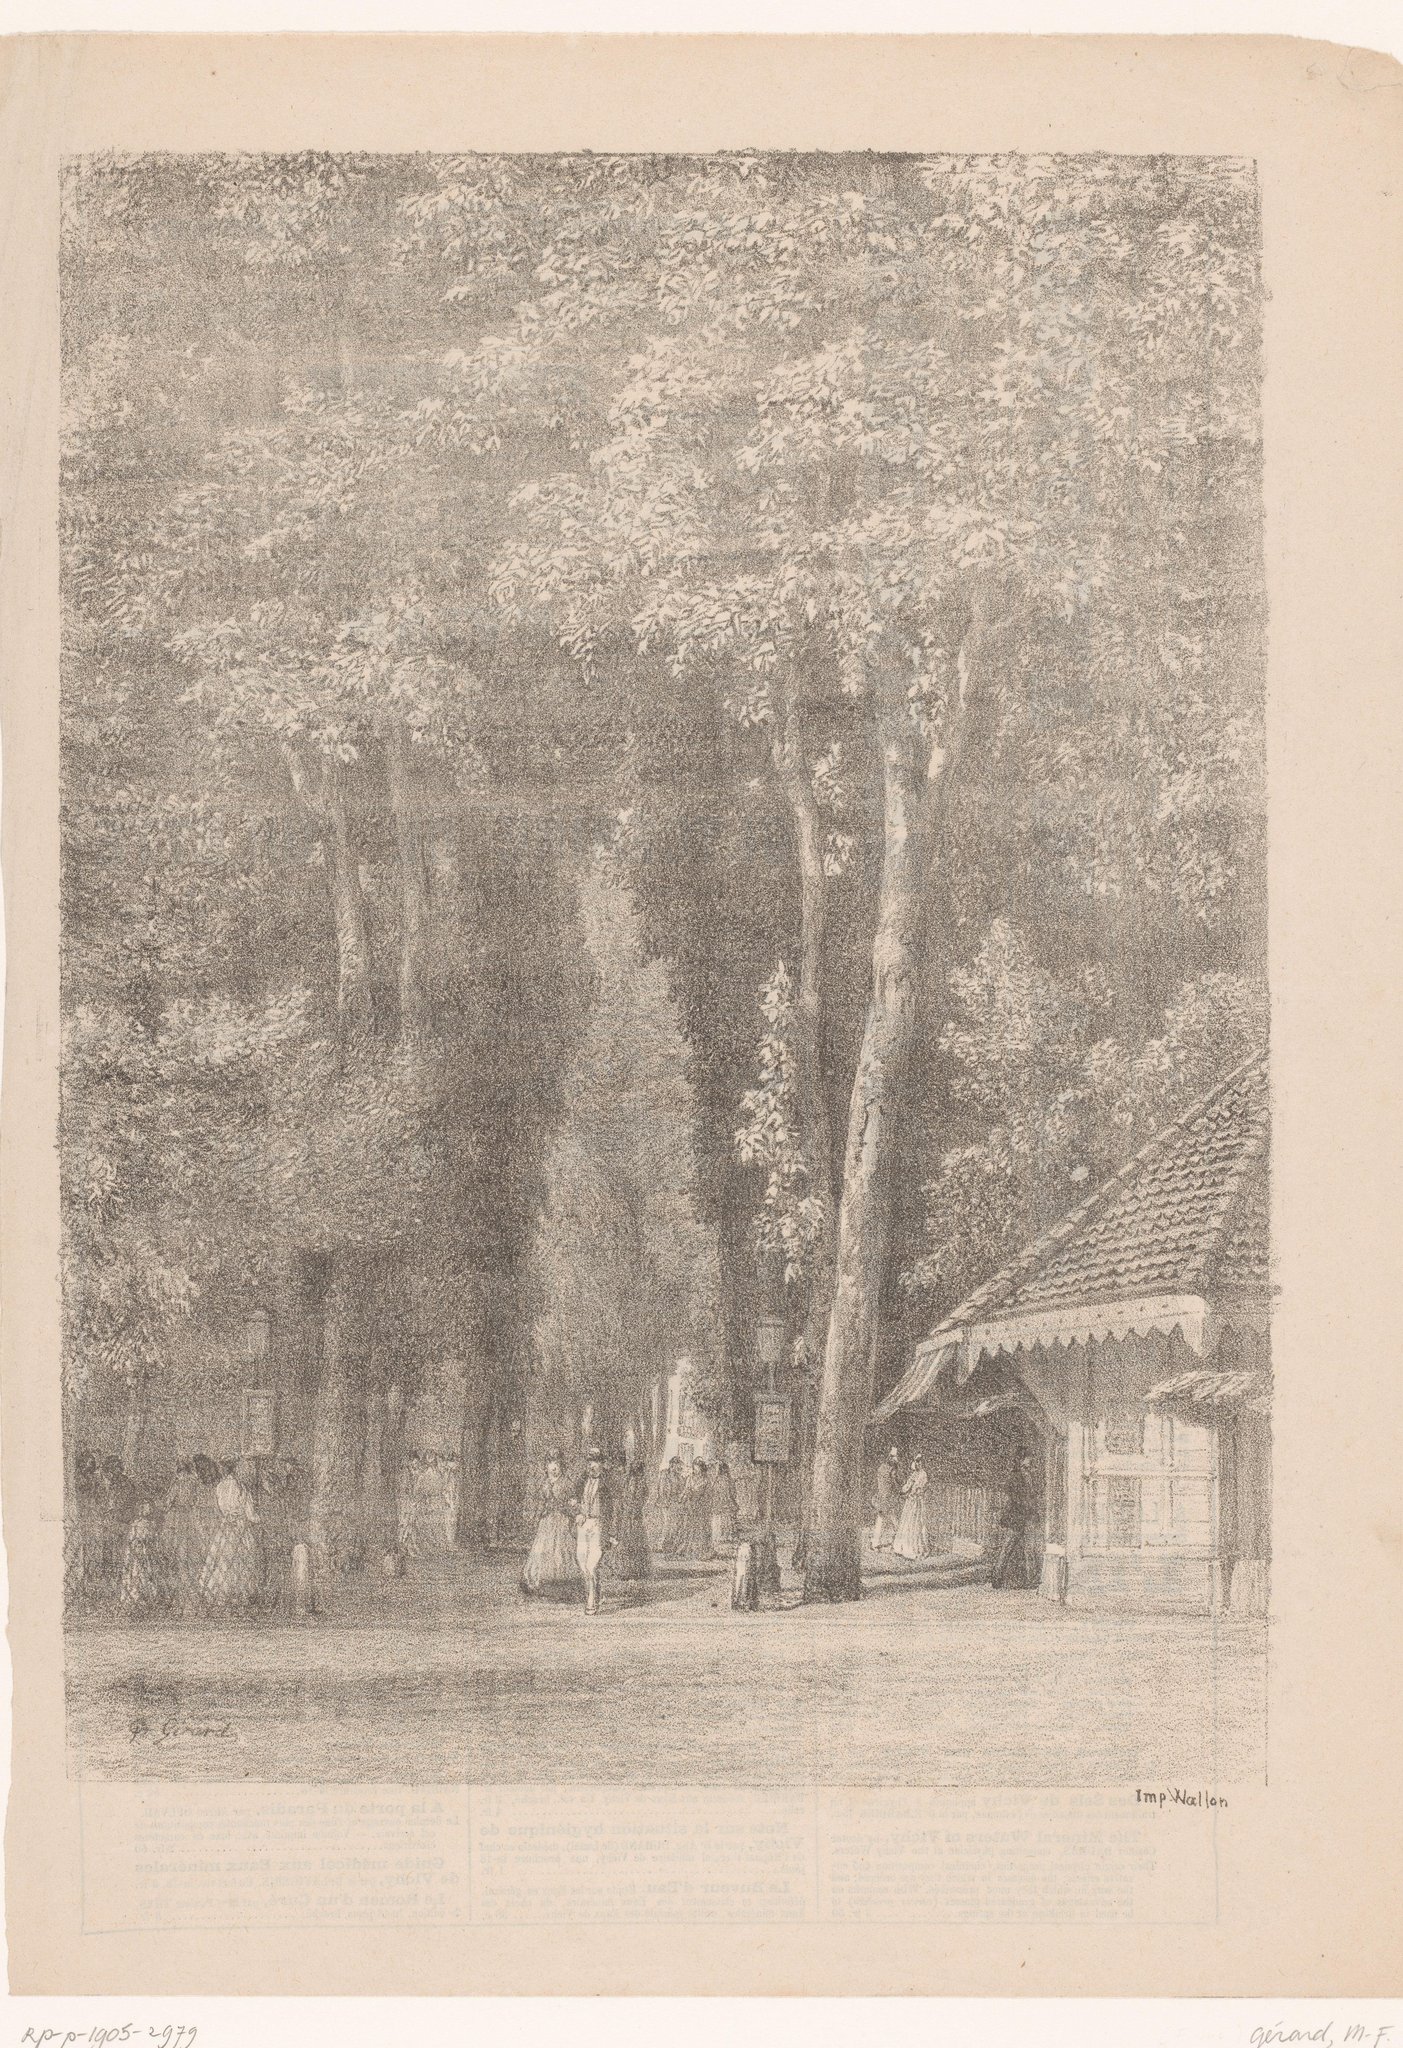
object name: print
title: Bosgezicht met wandelaars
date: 1866-1870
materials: paper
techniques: lithograph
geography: vichy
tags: forest, wood, walking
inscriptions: collector's mark: Lugt 2228a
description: Prent gebruikt voor: Le Programme de Vichy, een dagblad dat in Vichy werd uitgegeven tussen 1866 en 1870.